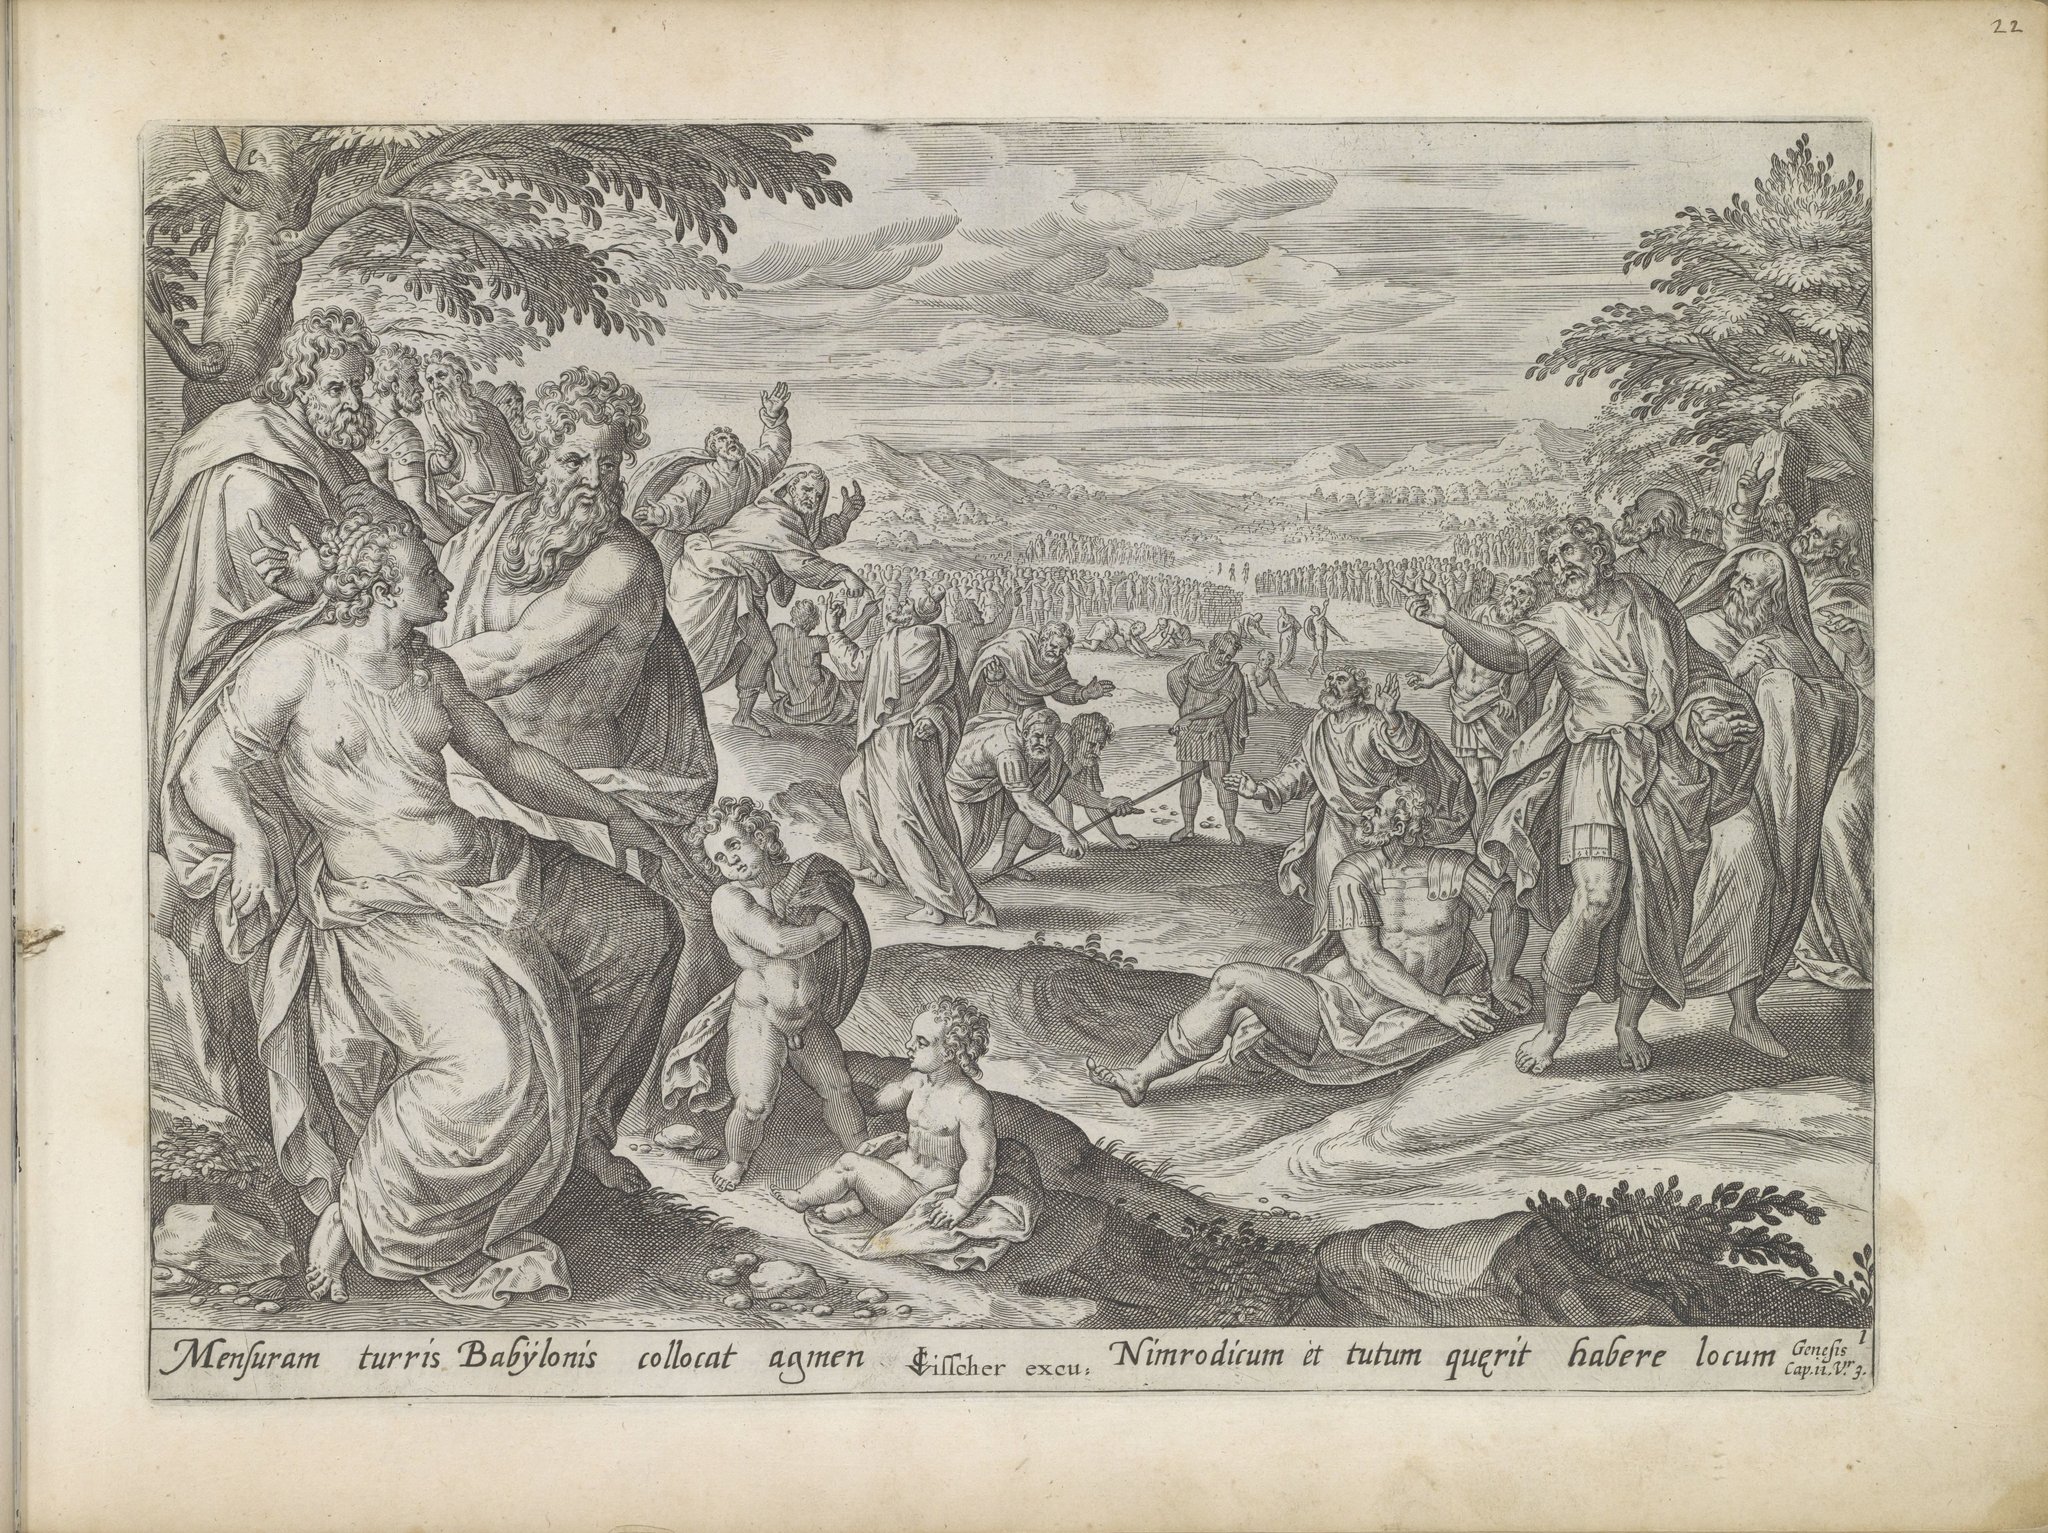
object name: album leaf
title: Geschiedenis van de toren van Babel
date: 1579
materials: paper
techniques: engraving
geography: amsterdam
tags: the building of the tower of babel; nimrod may be present, supervising or assisting the construction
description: Op een vlakte in Sinear geeft Nimrod de opdracht om de toren van Babel te bouwen. De grond wordt gemeten en geschikt gemaakt voor de bouw. Onder de voorstelling een verwijzing in het Latijn naar de Bijbeltekst in Gen. 11:3. Deze prent maakt deel uit van een album.